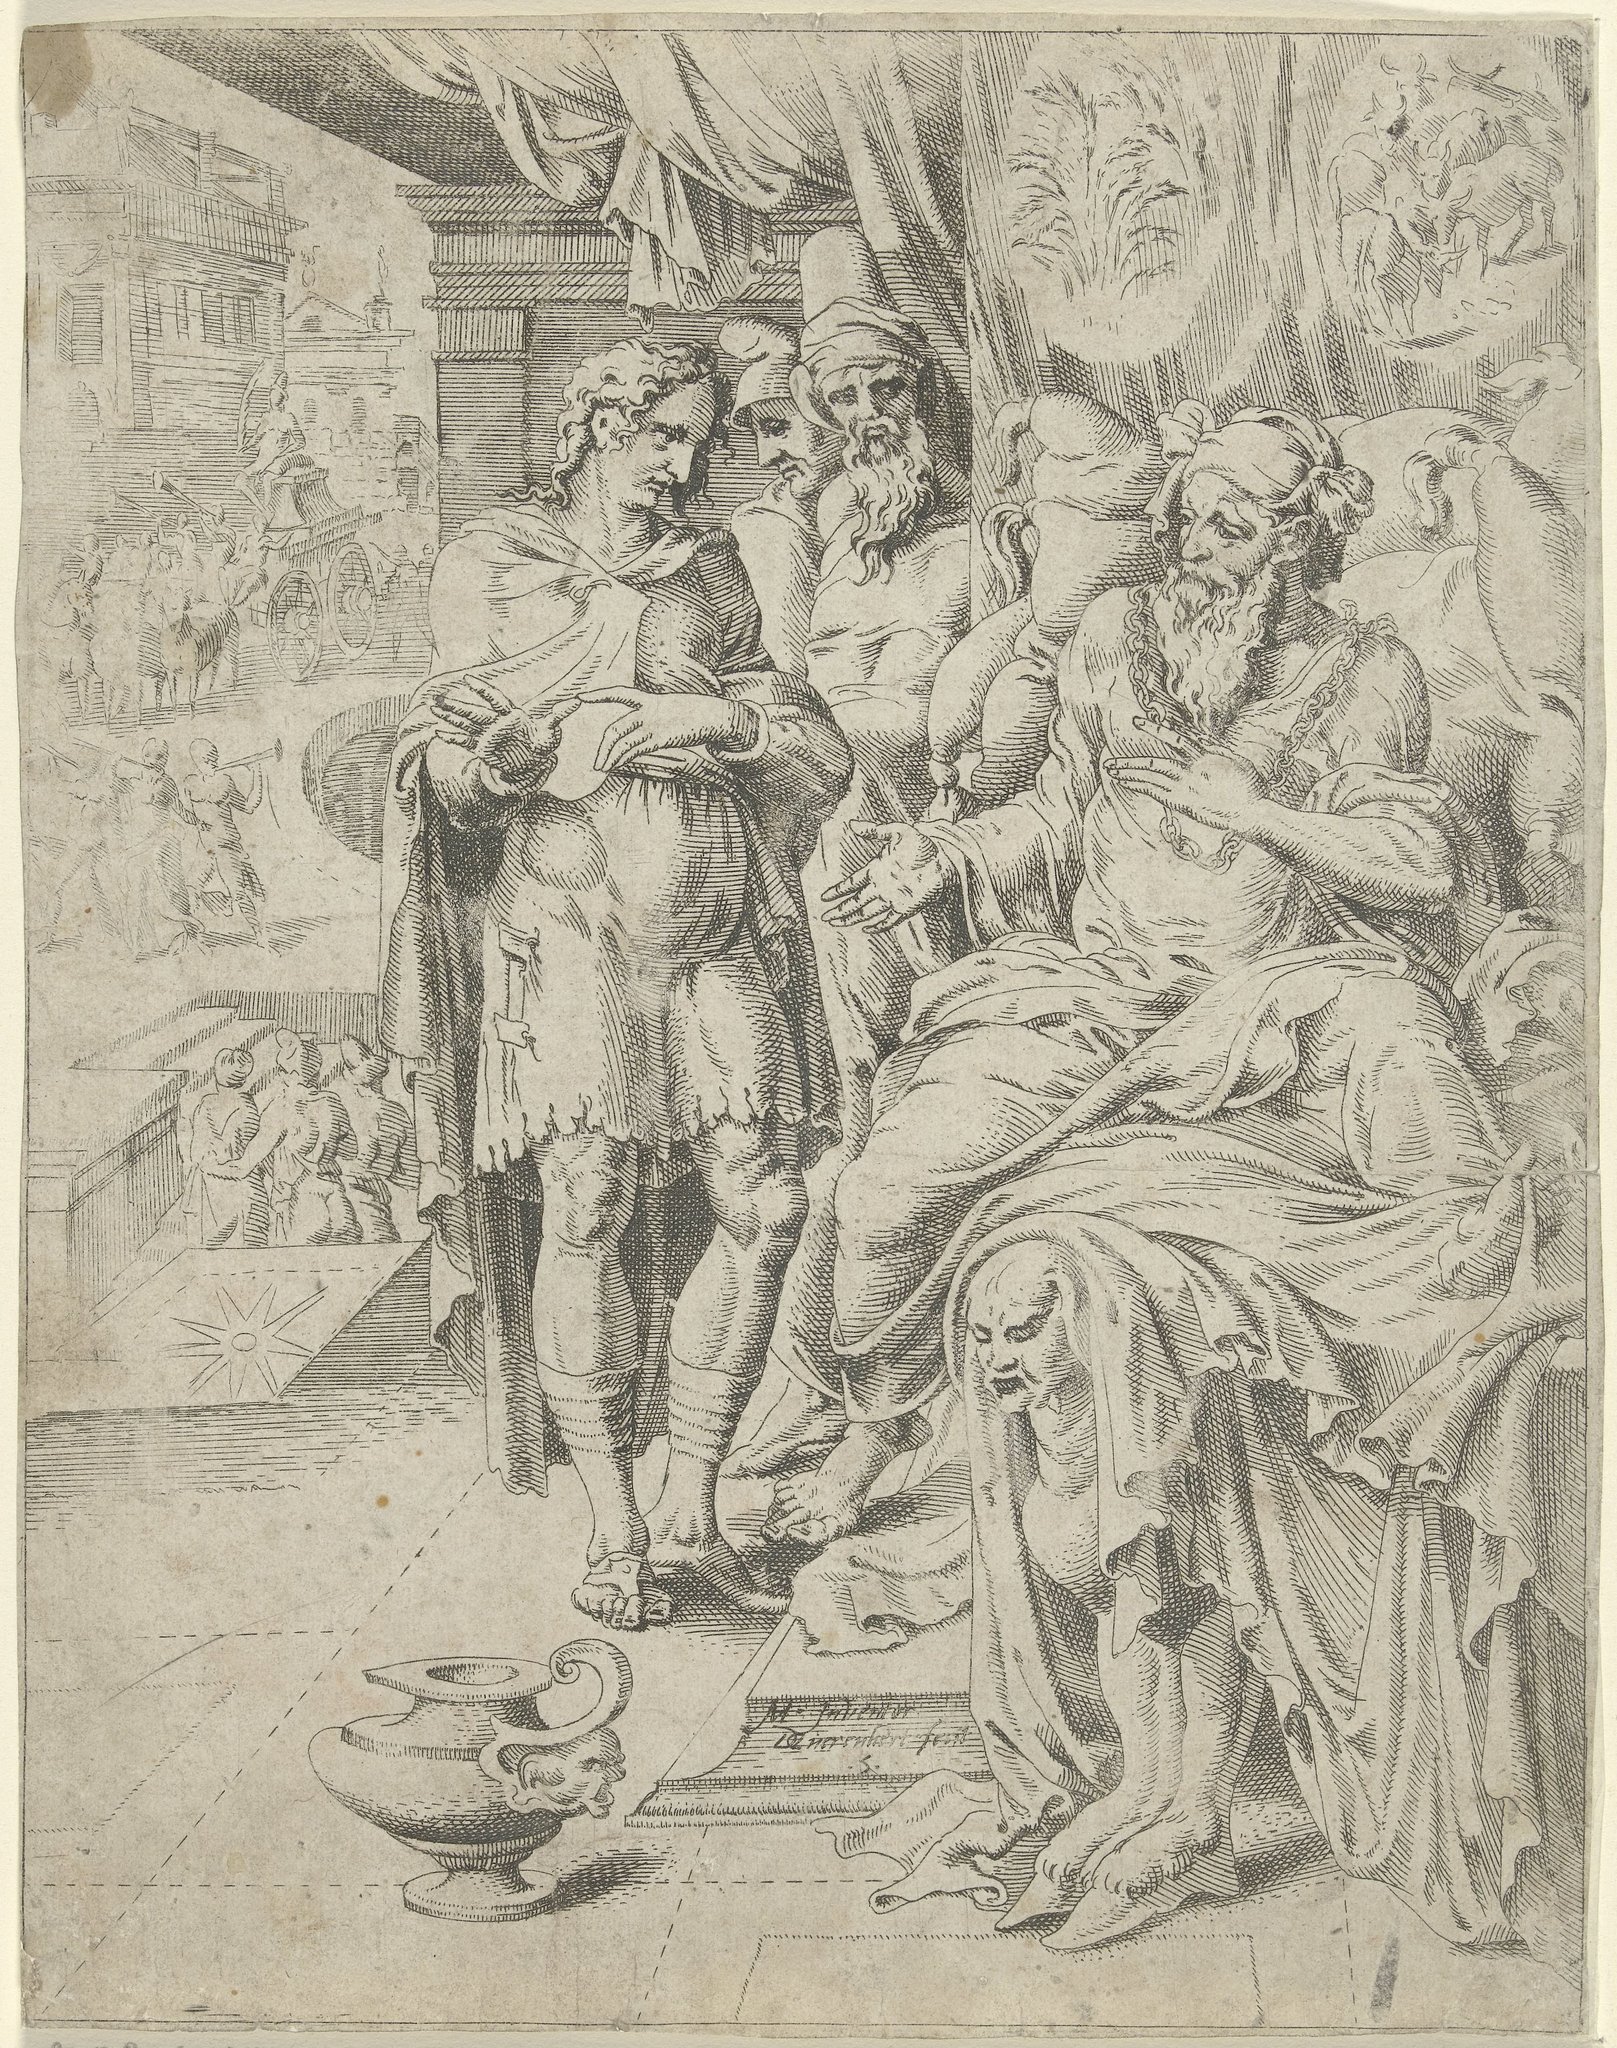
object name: print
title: Geschiedenis van Jozef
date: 1549-1550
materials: paper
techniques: etching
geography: haarlem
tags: container of ceramics: jar, jug, pot, vase, triumph of joseph: dressed in a royal attire he rides in one of pharaoh's chariots, preceded by a herald, interpretation of the dream of the thin and the full ears of corn, interpretation of the dream of the lean and the fat cows, animals with human head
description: Jozef staat voor de troon van de farao en legt hem uit dat de zeven vette en de zeven magere koeien in zijn droom staan voor zeven goede en zeven slechte oogstjaren. Op de achtergrond van de prent wordt Jozef geëerd in Egypte. De prent maakt deel uit van een serie over de geschiedenis van Jozef.